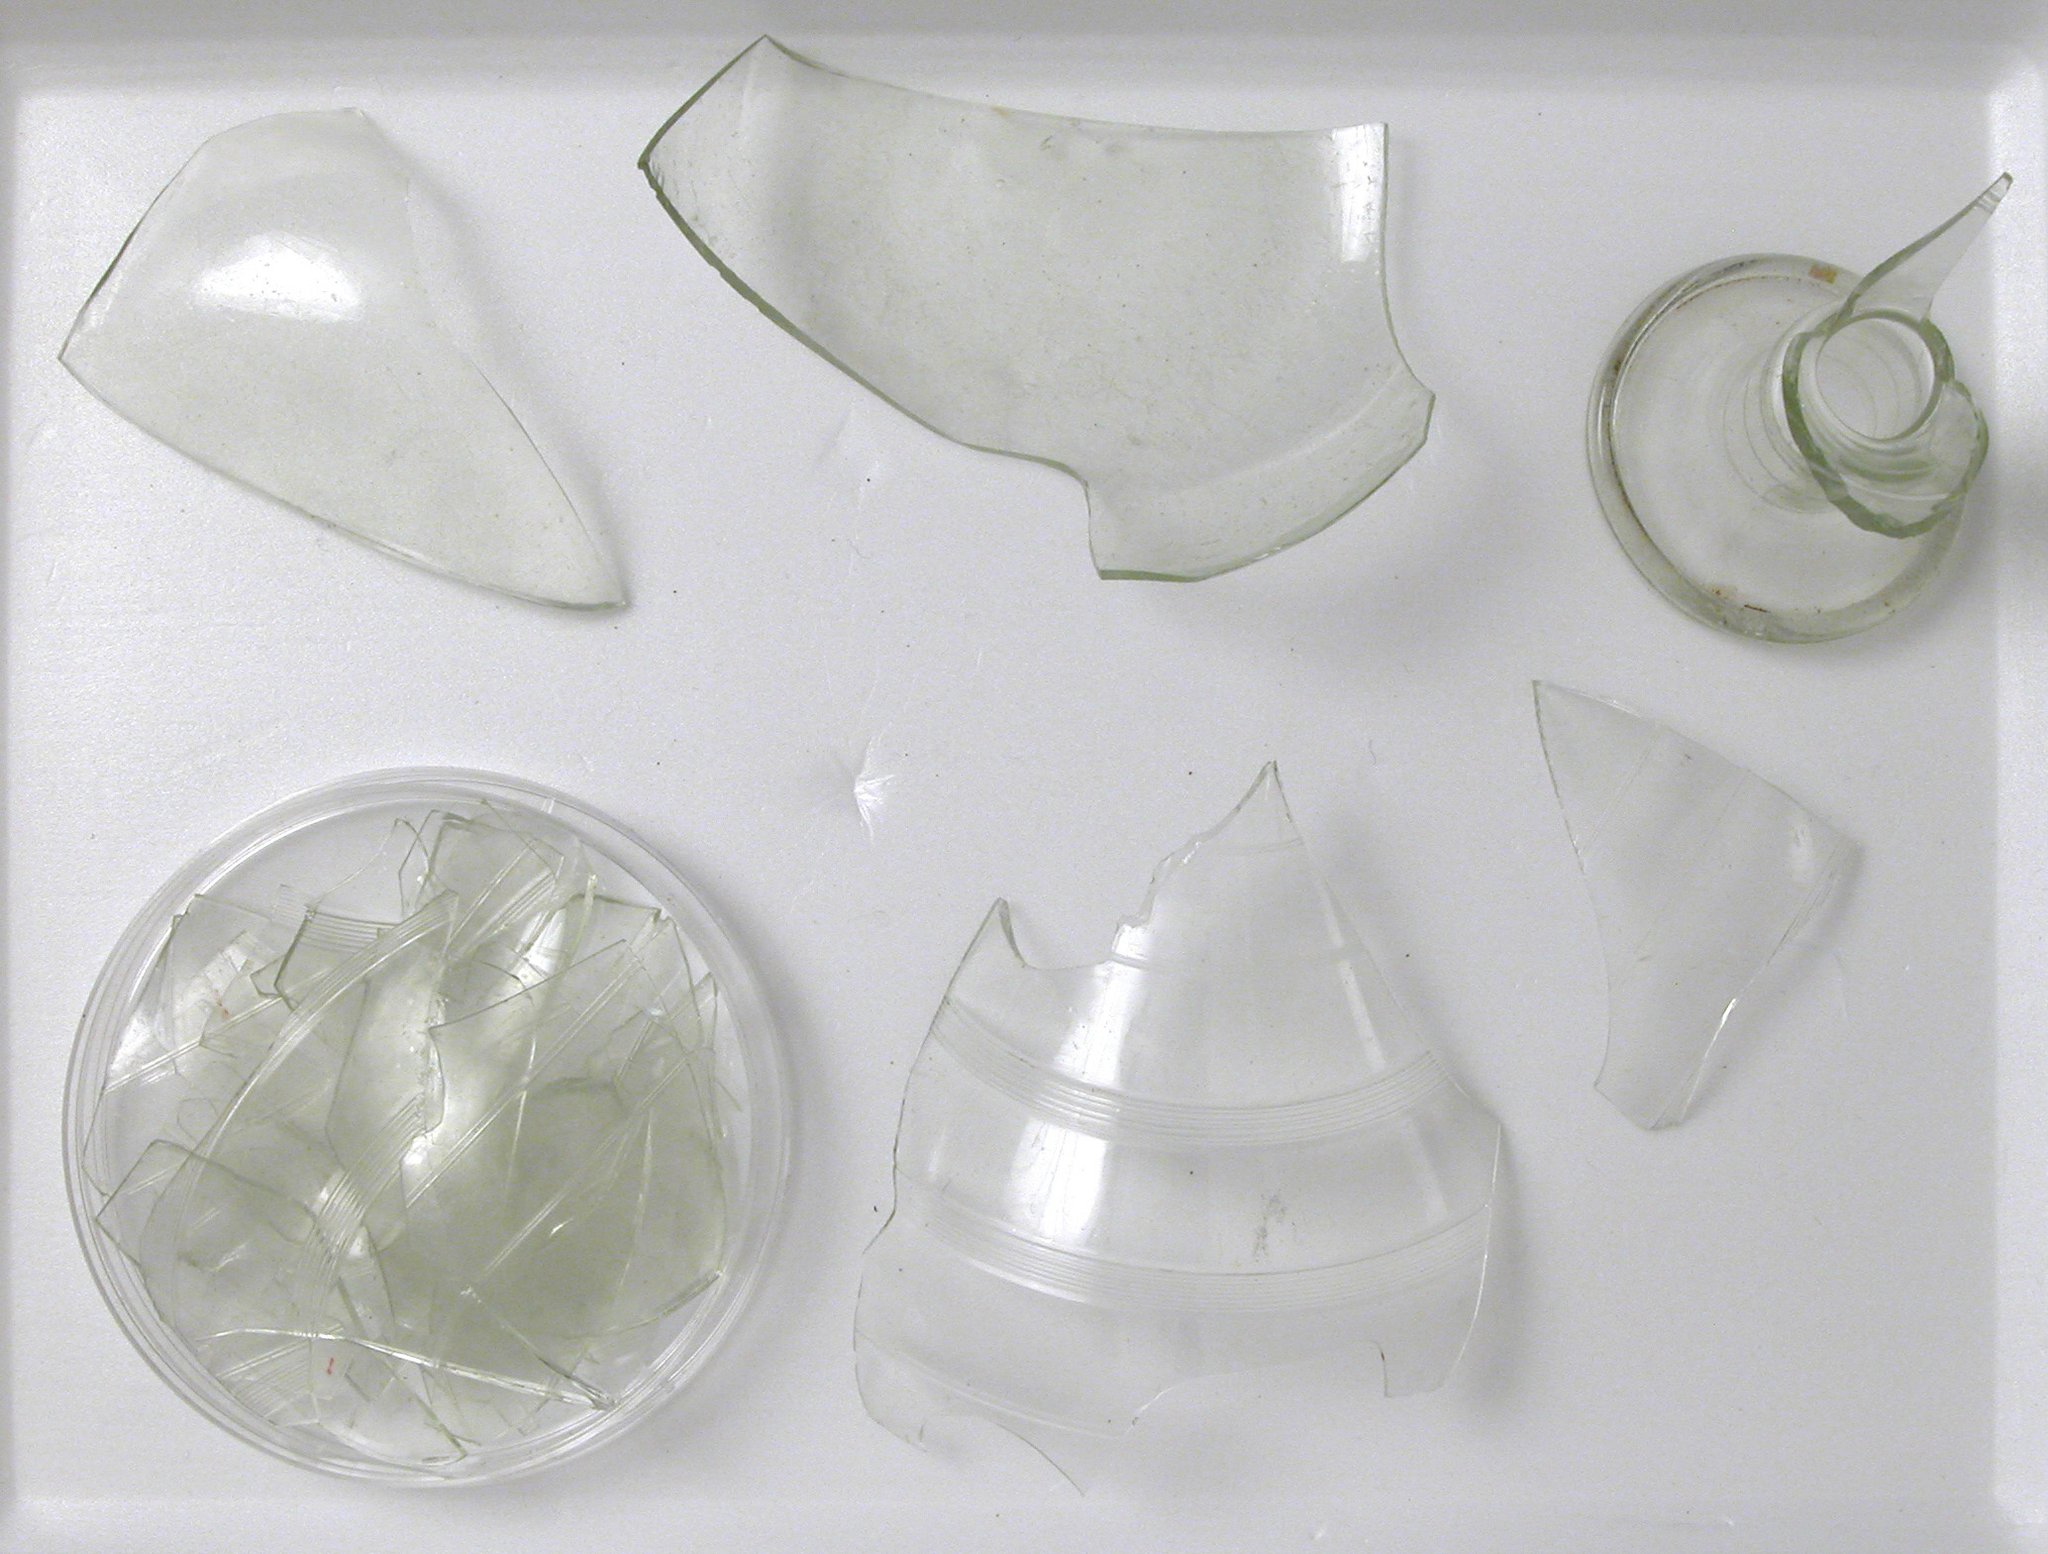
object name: bottle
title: Bottle Fragments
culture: coptic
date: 301-400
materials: glass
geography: egypt